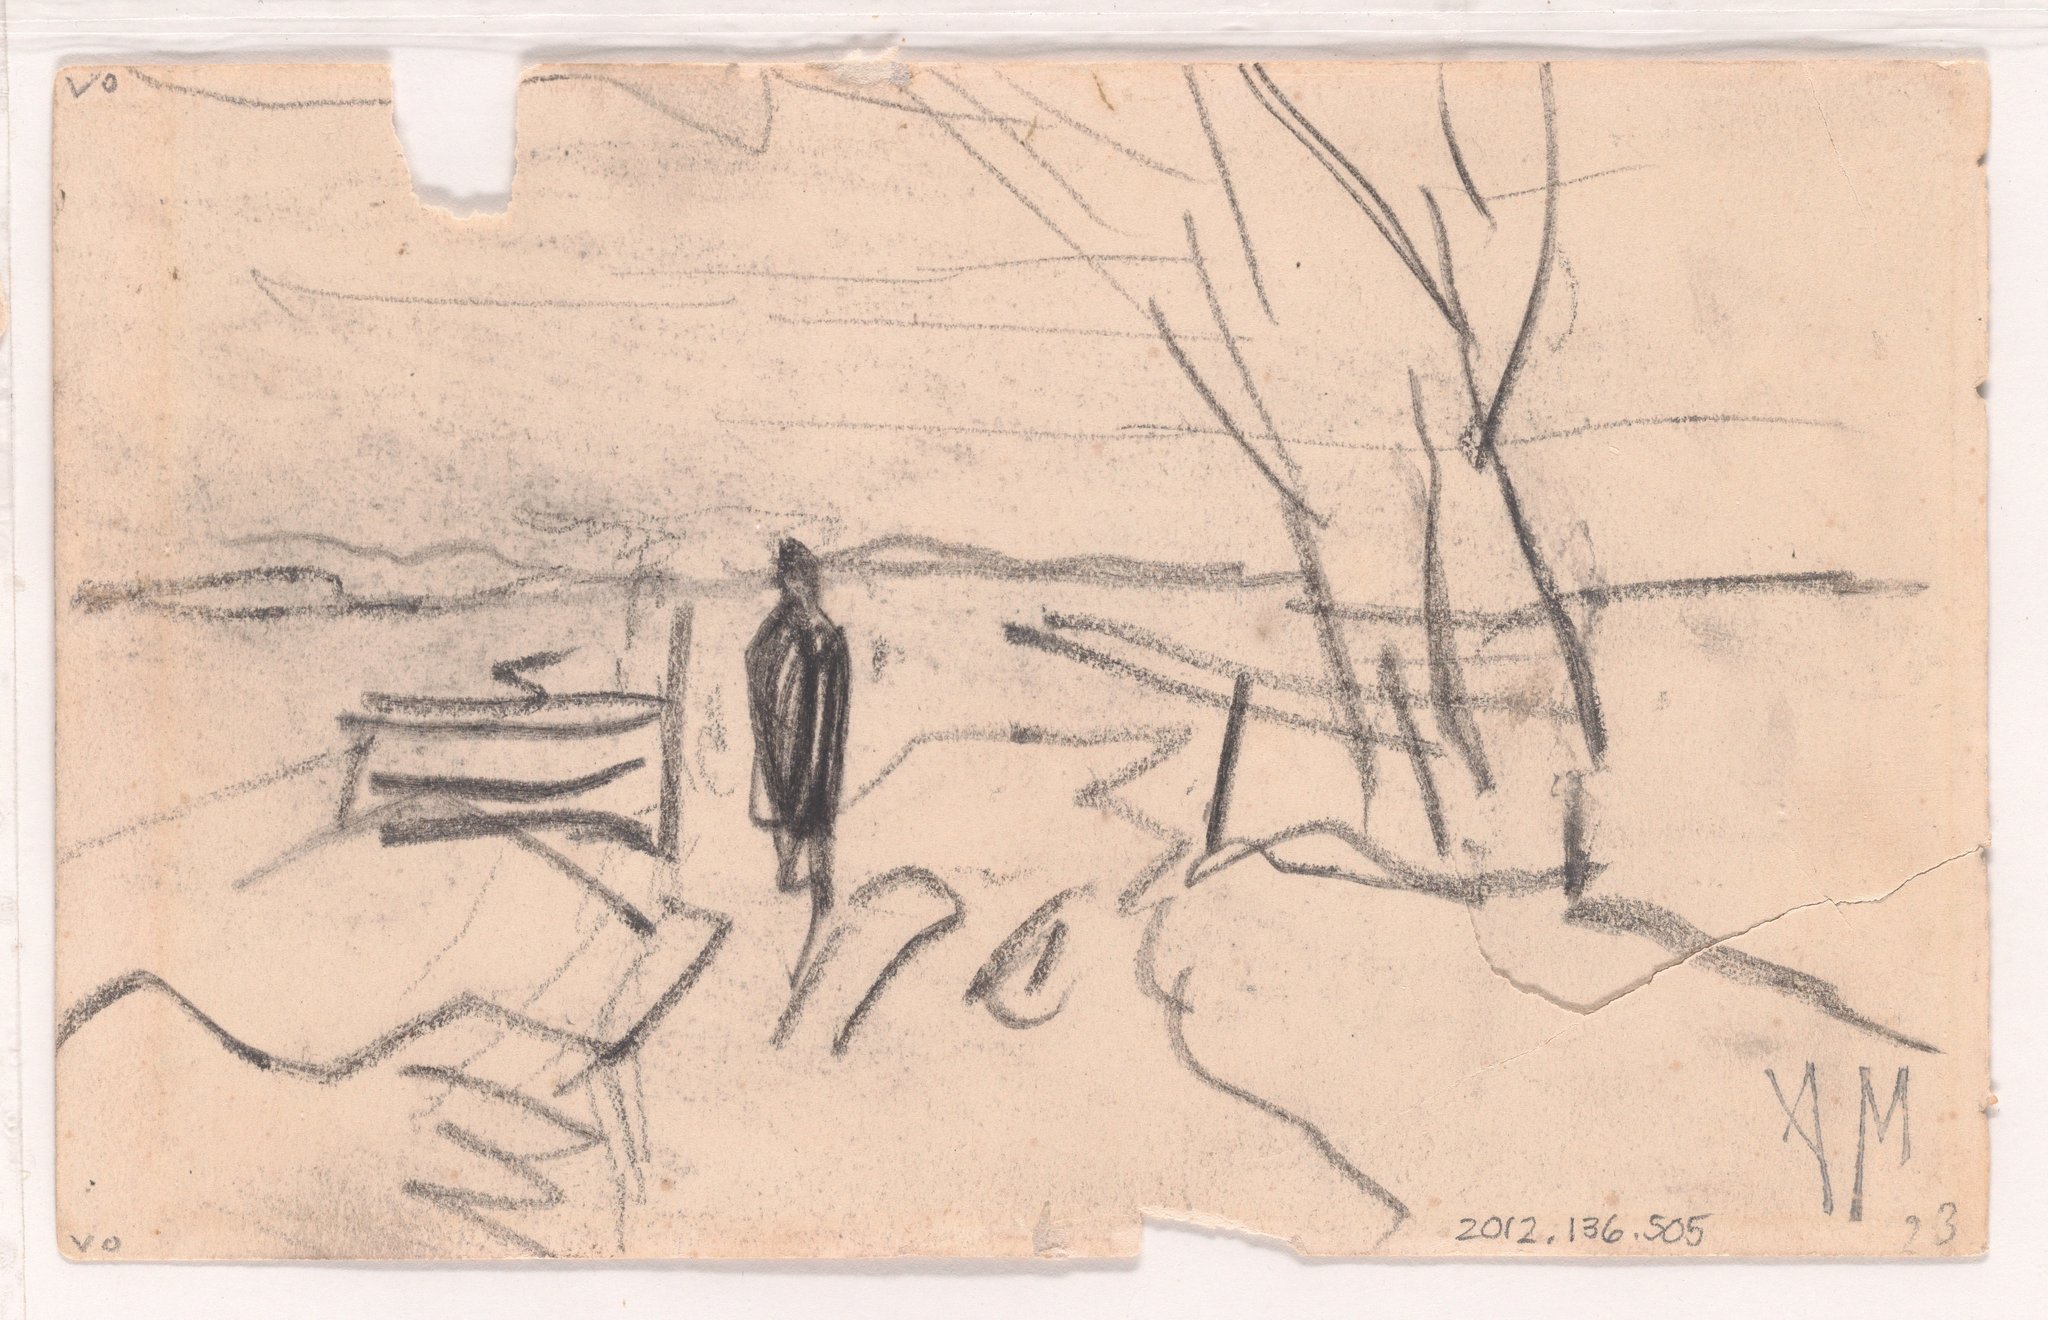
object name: drawing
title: Landscape with Women Working in a Field (recto); Sketch of Landscape with Person on a Path (verso)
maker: anton mauve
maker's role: artist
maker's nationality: dutch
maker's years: 1838-1888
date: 1801-1900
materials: charcoal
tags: landscapes